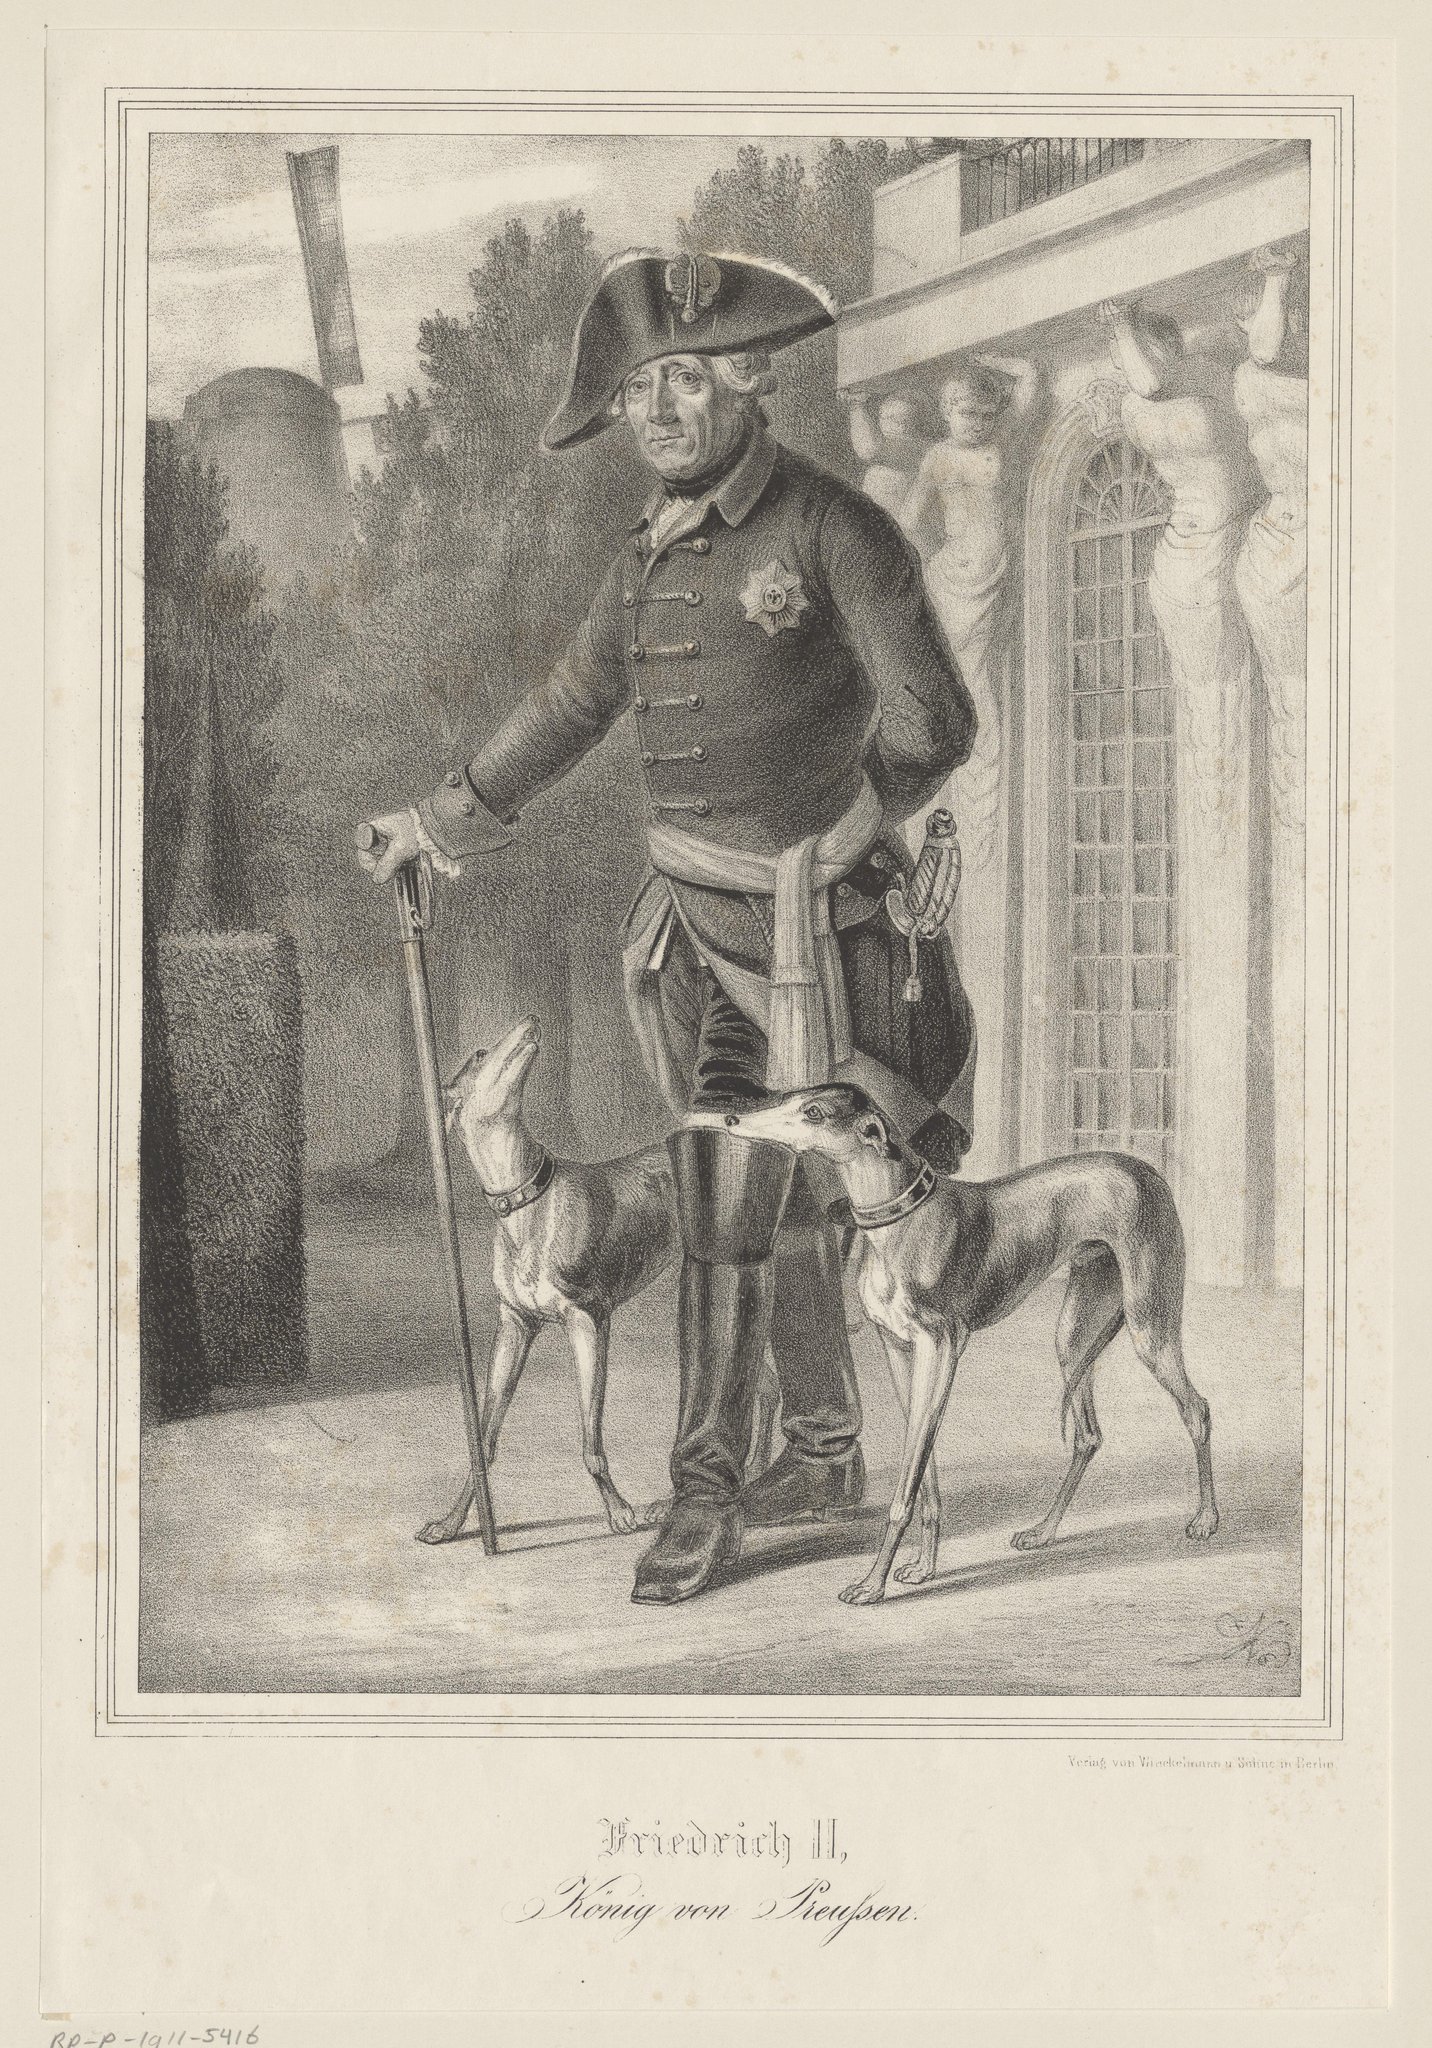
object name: print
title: Portret van Frederik de Grote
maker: Anonymous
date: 1830-1899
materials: paper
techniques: lithograph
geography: berlin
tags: berlin, frederick ii (king of prussia), historical persons, garden buildings, (military) uniforms, windmill, king, dog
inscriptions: monogram: ‘VH (?)’, collector's mark: Lugt 2228